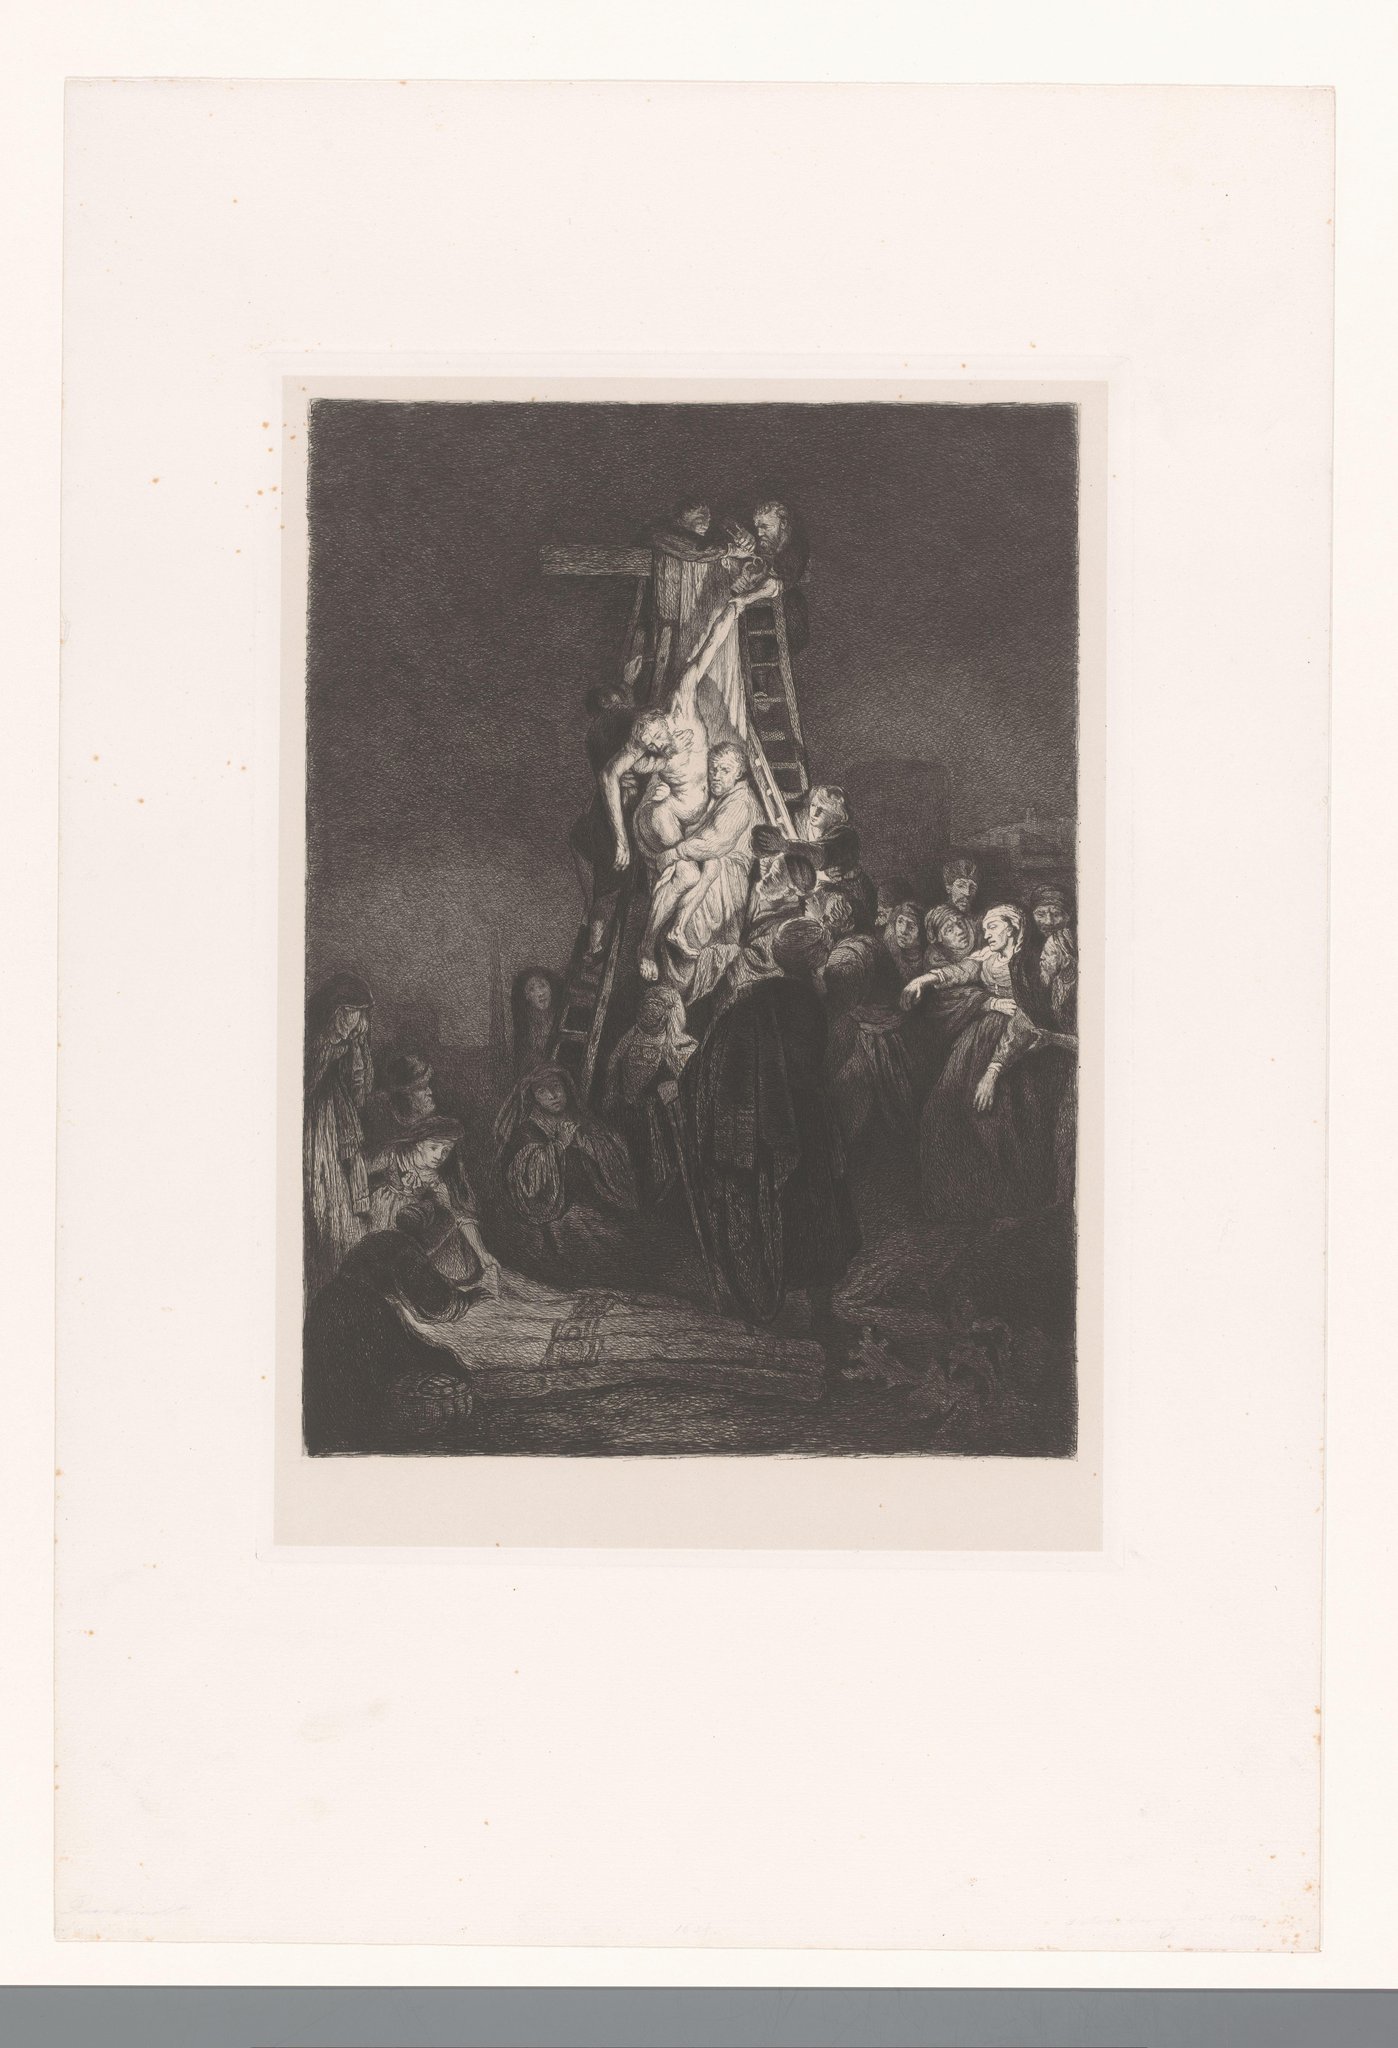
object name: print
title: Kruisafname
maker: nikolay semyonovich mosolov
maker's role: print maker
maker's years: 1847-1914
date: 1857-1914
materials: paper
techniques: drypoint, etching, intaglio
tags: descent from the cross: christ is taken down from the cross, usually by nicodemus and joseph of arimathaea who are standing on the ladders (both arms of christ detached)